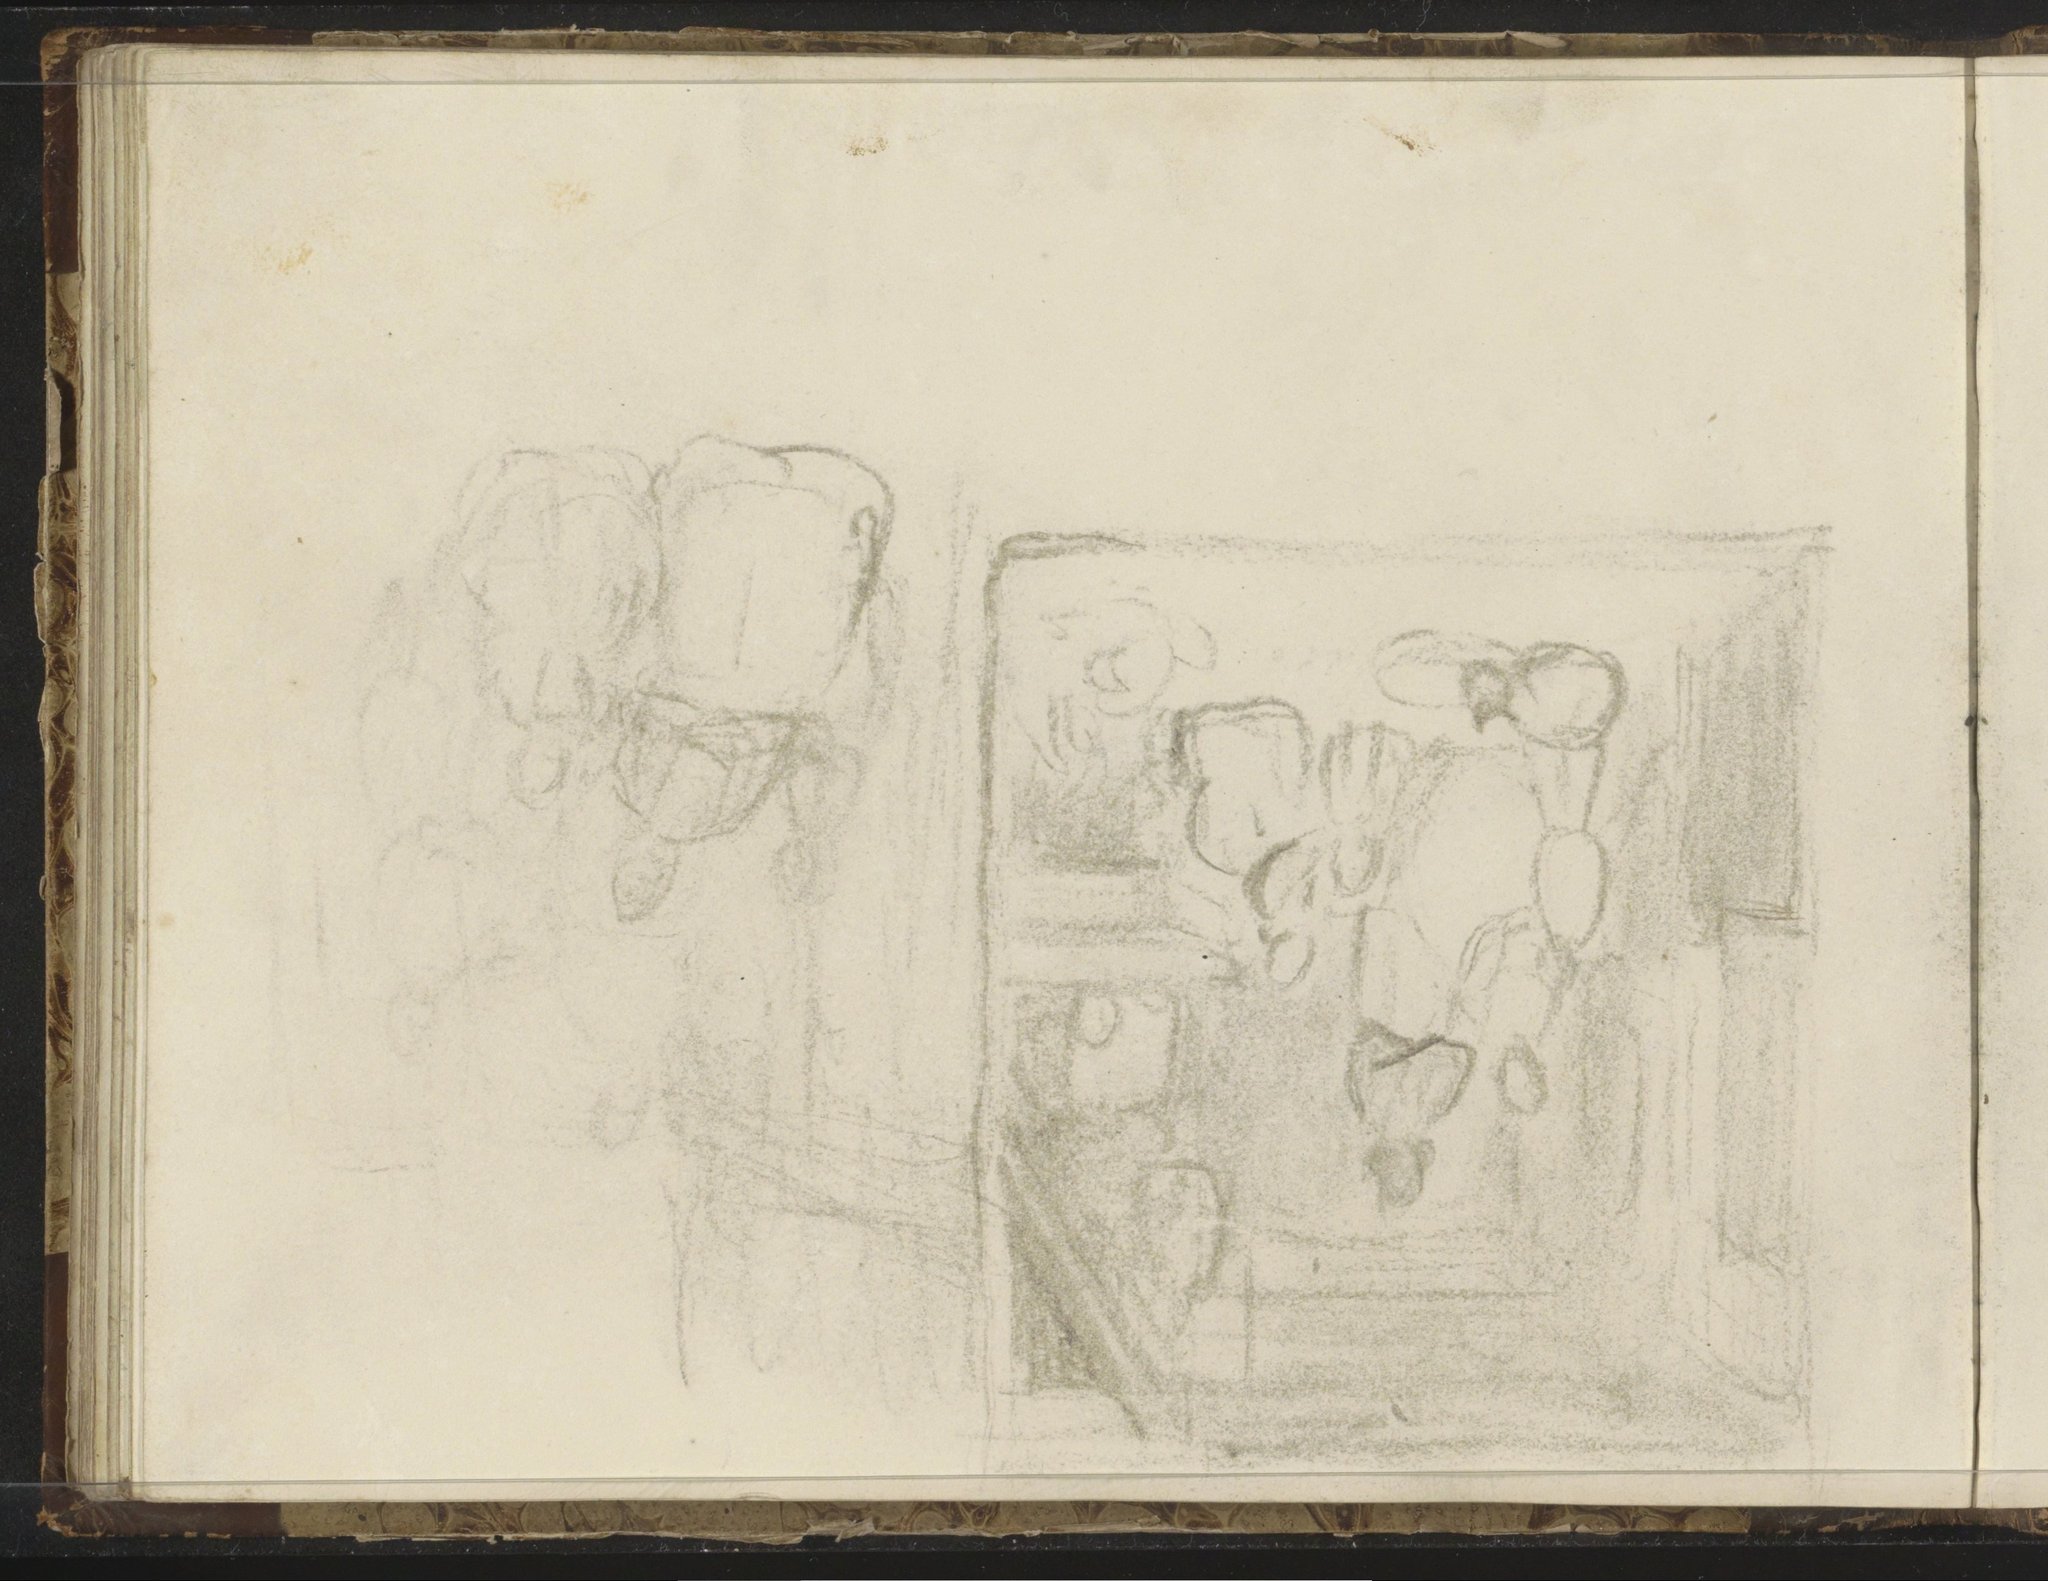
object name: sketchbook leaf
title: Interieur met vrouwen, kinderen en een kat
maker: willem hendrik schmidt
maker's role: draughtsman, painter, print maker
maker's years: 1809-1849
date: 1819-1849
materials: chalk, paper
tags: cottage - aa - civic architecture: inside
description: Tevens een studie van een vrouw en kinderen in een interieur. Blad 45 verso uit een schetsboek met 52 bladen.